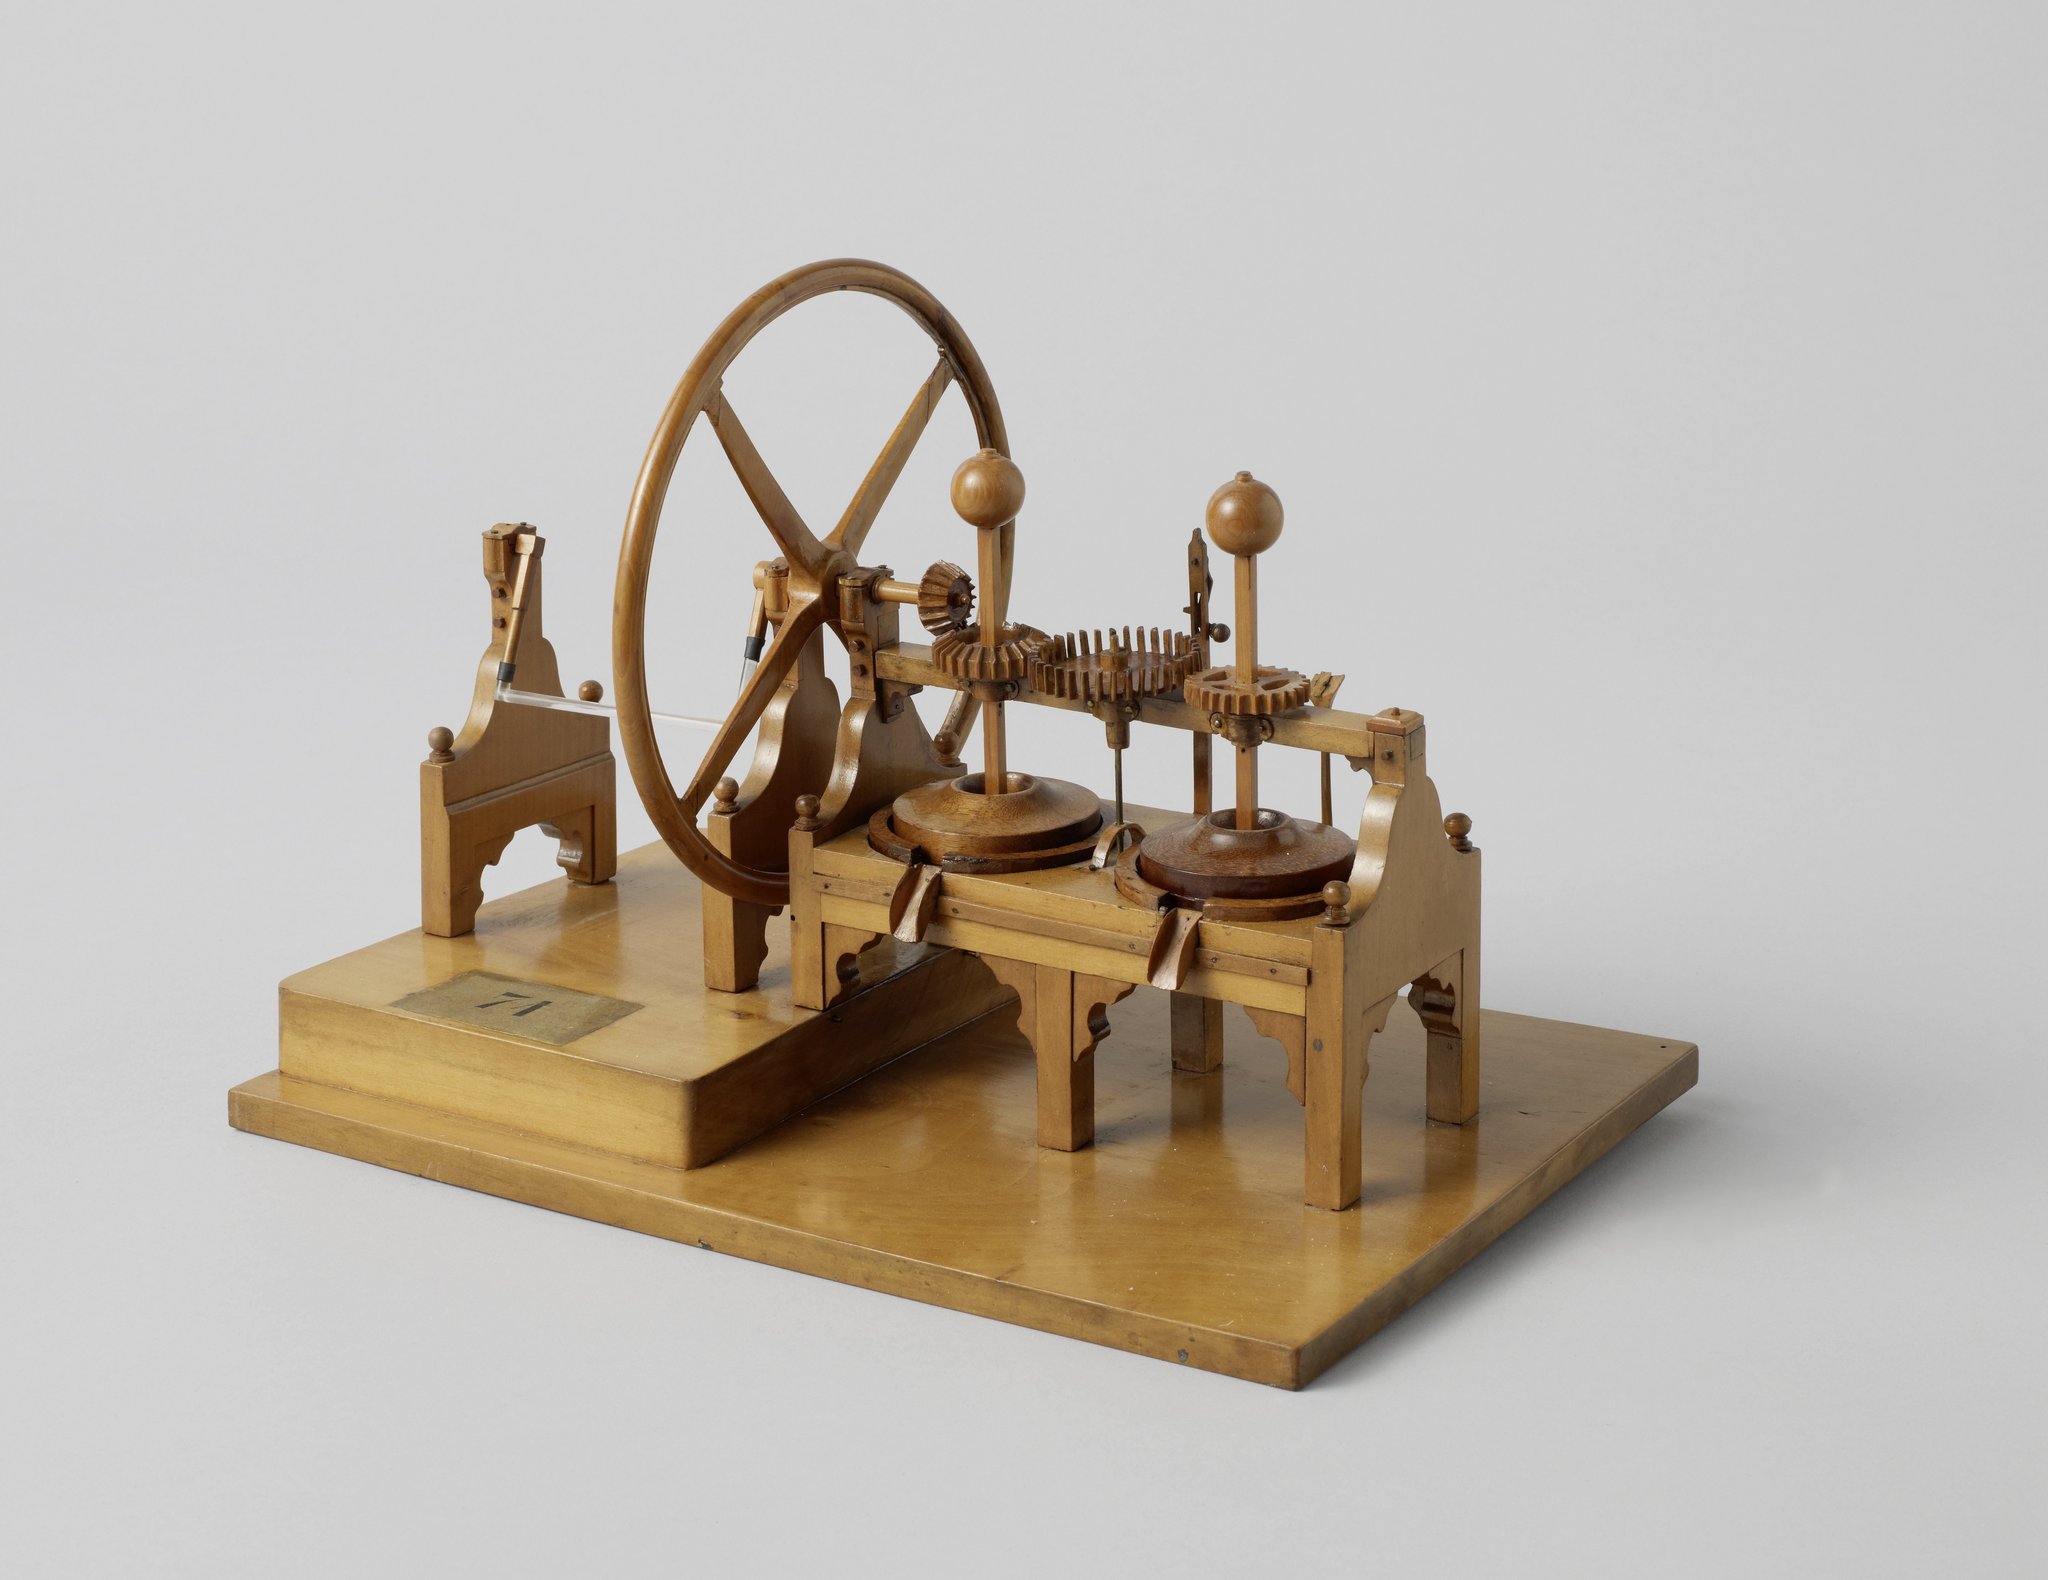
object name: demonstration model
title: Model of a Colour Mill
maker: l. cramer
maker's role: timmerman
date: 1842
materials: brass, wood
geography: hellevoetsluis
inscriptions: label, left corner: ‘71’ former inventory label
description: Twee molenstenen worden aangedreven door een raderwerk met vliegwiel en twee verfstoffen kunnen dus tegelijkertijd gemalen worden. De molen is uitgevonden door de commandeur der smeden van de Rijkswerf te Hellevoetsluis L. Groeneveld en op de werf geinstalleerd. Cramer was huistimmerman op dezelfde werf en werd voor dit model bevorderd.